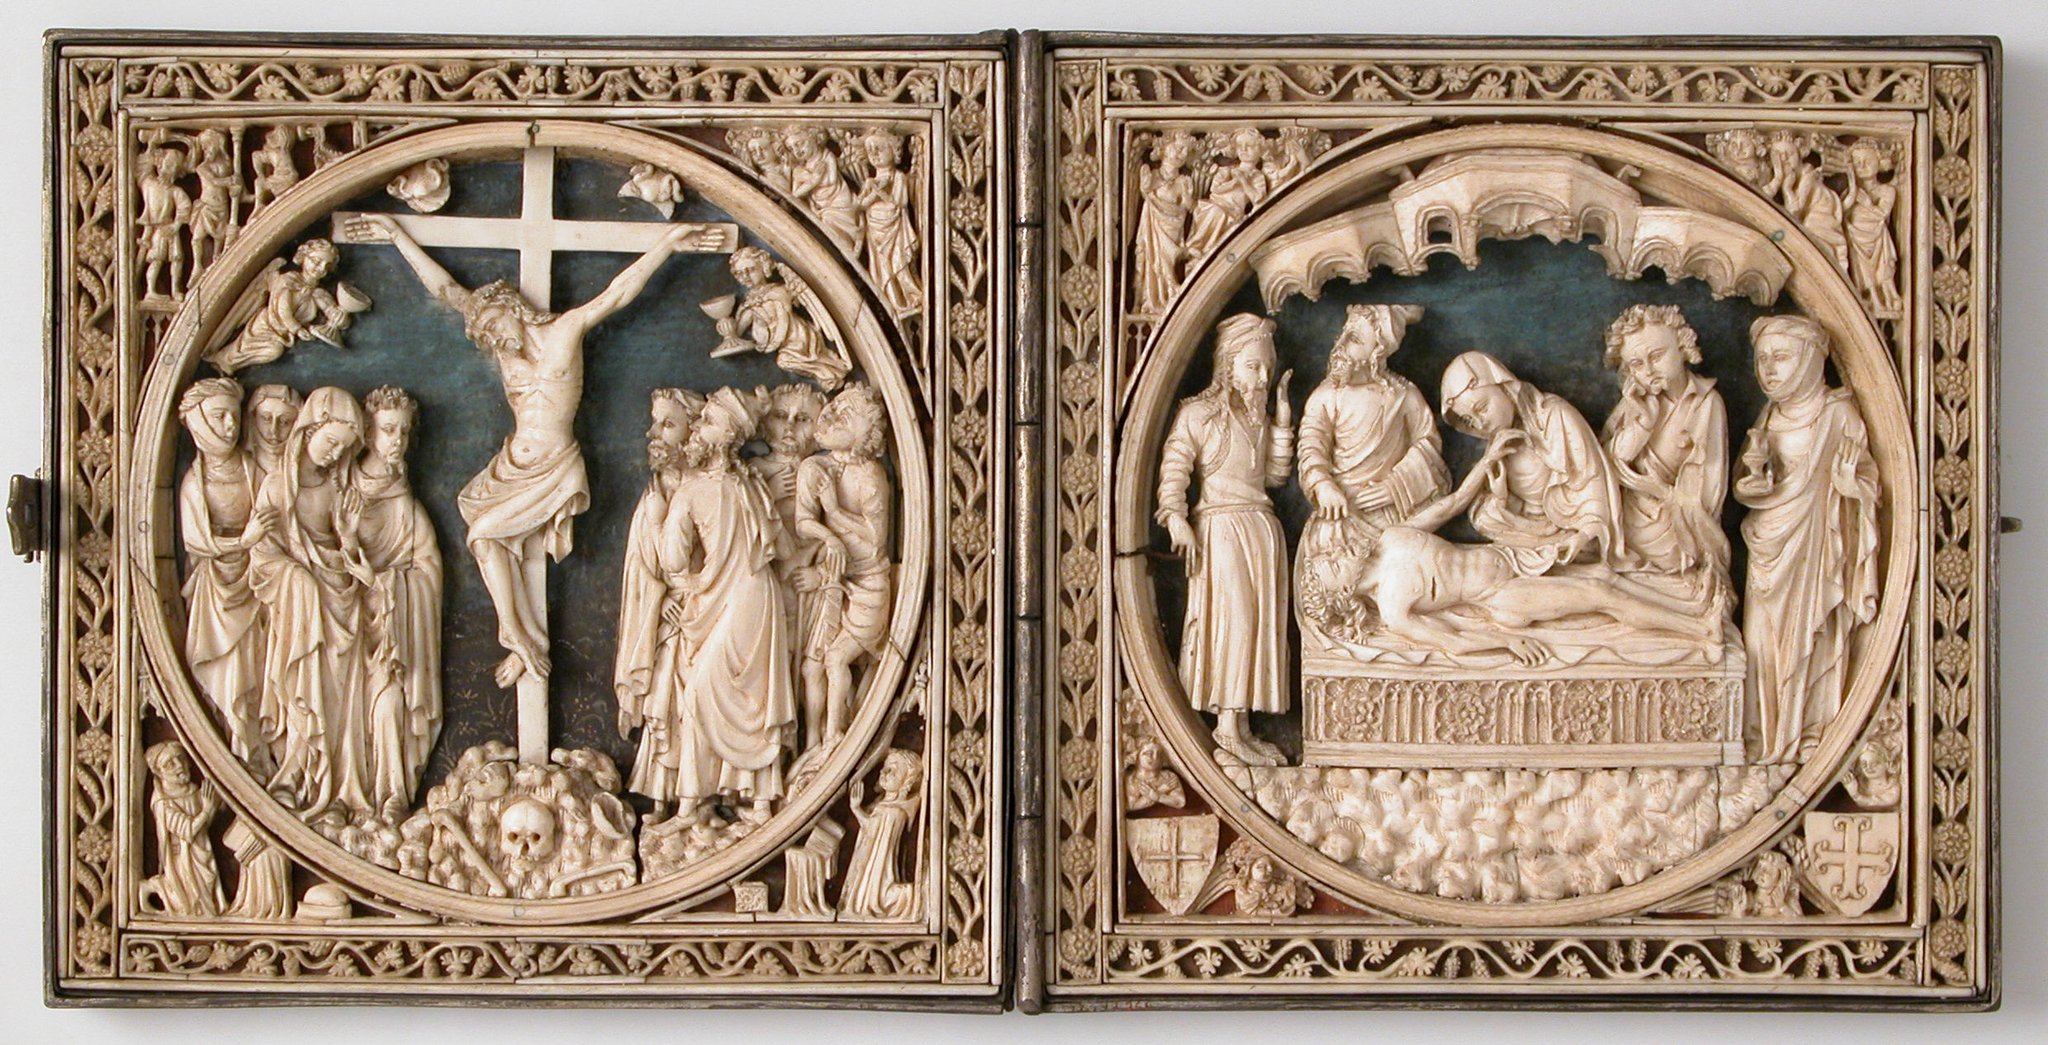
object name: diptych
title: Diptych with the Passion of Jesus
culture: dutch or french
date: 1400-1450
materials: ivory, parchment, pigment, silver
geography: france or netherlands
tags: christ,crucifixion,coat of arms